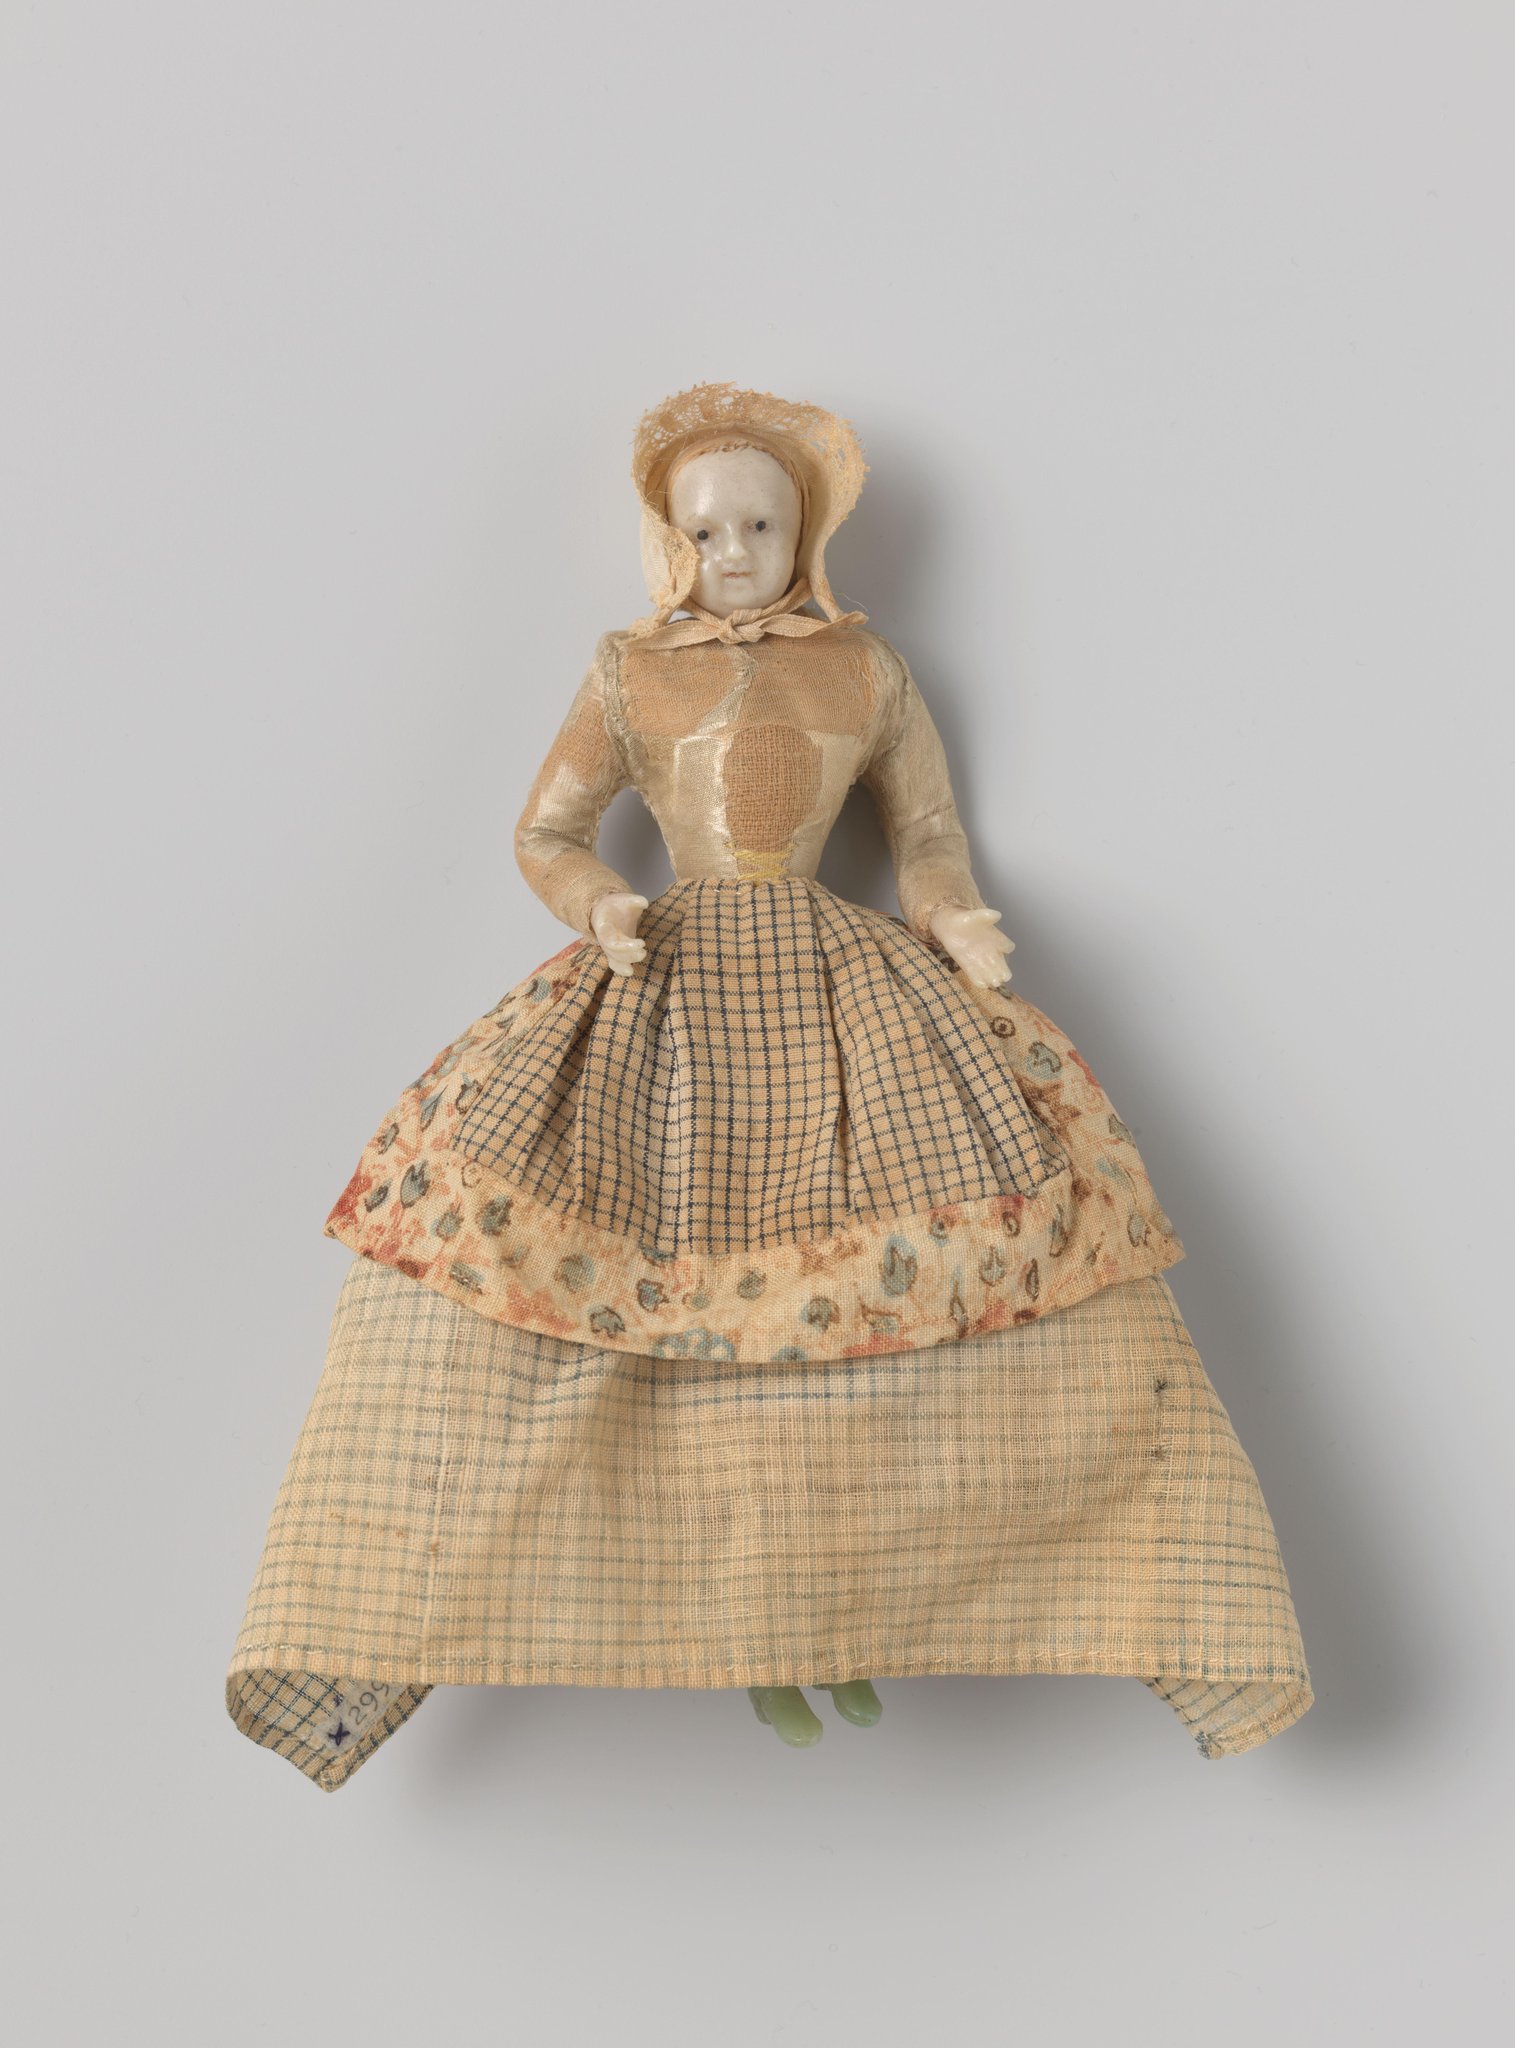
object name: miniature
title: Pop, voorstellende een eenvoudige vrouw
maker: Anonymous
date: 1750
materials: cotton, linen, silk, wax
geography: amsterdam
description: Pop, voorstellende een eenvoudige vrouw (meid?). Hoofd, handen en onderbenen van was.